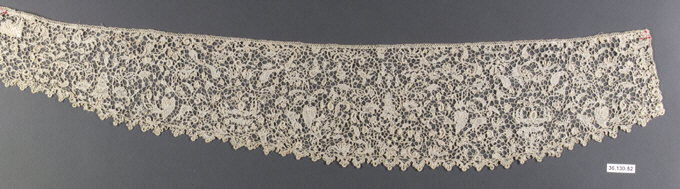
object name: sleeve trimming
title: Sleeve ruffle (one of a pair)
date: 1701-1733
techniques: lace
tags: flowers